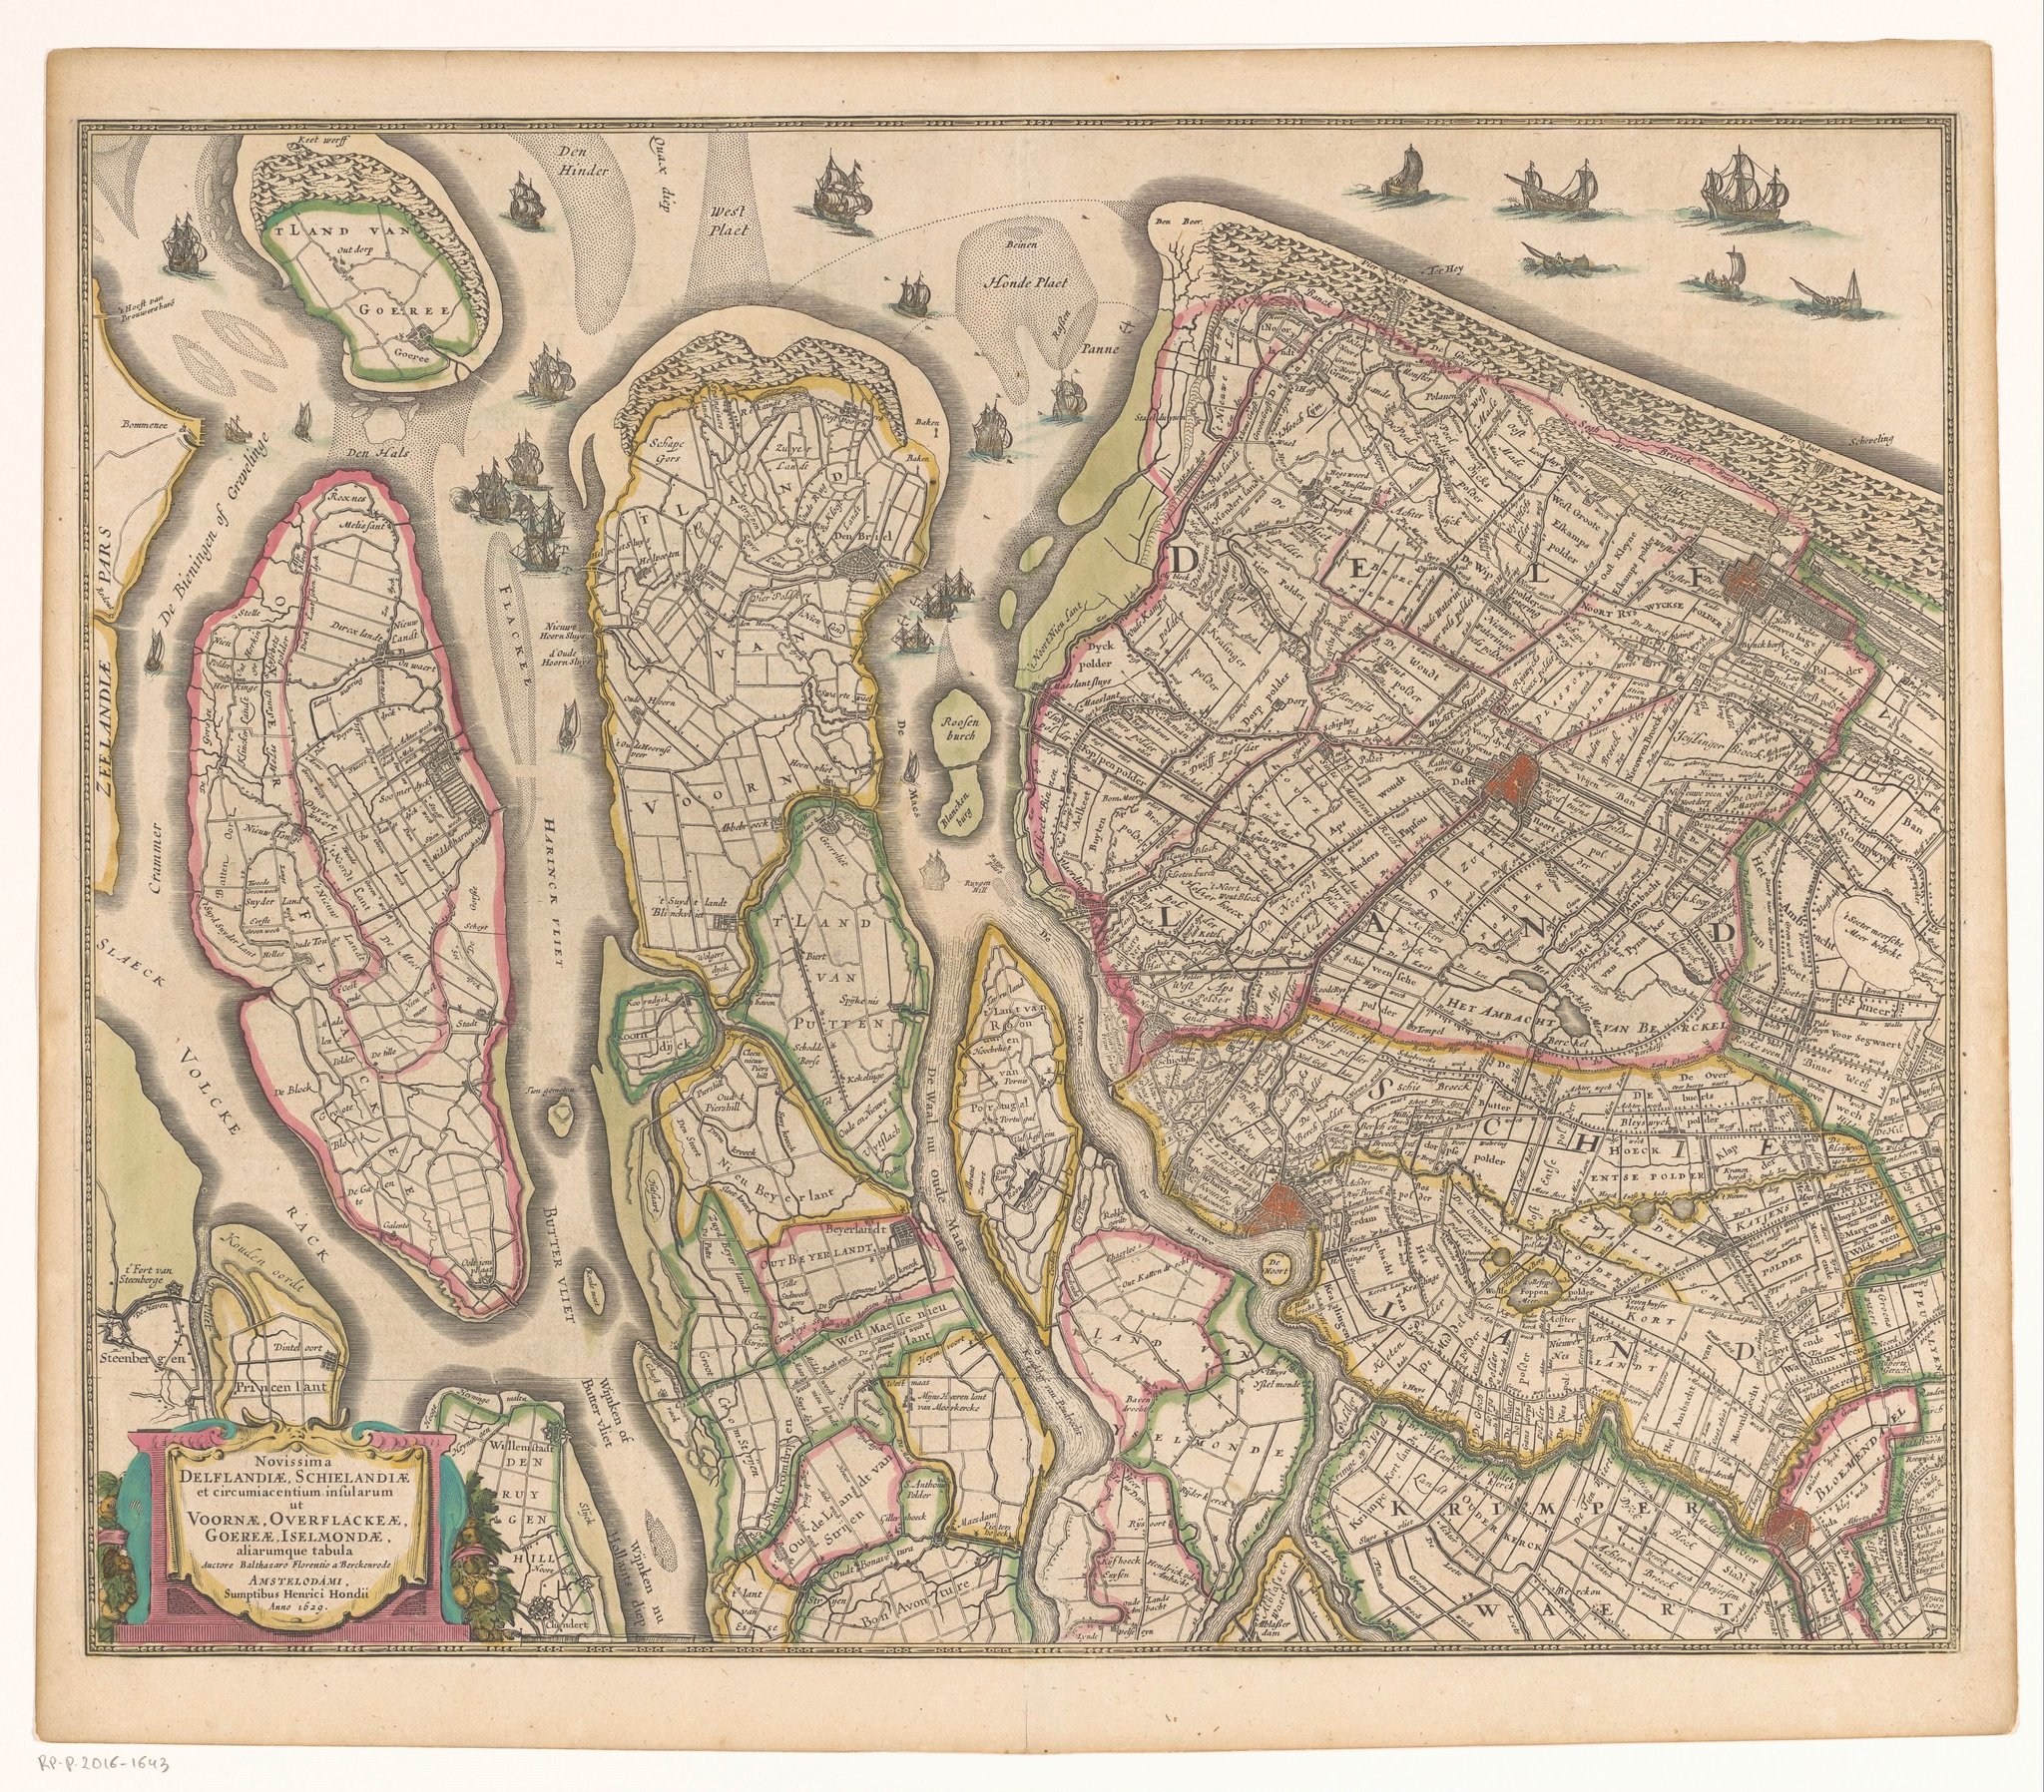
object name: print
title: Novissima Delflandiae, Schielandiae et circumiacentium insularum ut Voornae, Overflackeae, Goereae, Iselmondae, aliarumque tabula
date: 1638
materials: paper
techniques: engraving, etching, hand coloring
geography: amsterdam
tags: maps of separate countries or regions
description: Kaart van Delfland, Schieland en de Zuid-Hollandse eilanden (onder andere Voorne, Overflakkee, Goeree en IJsselmonde). Linksonder de titelcartouche. Rechts daarvan een schaalstok zonder maat. Oriëntatie: noorden rechts. Op verso Latijnse tekst.